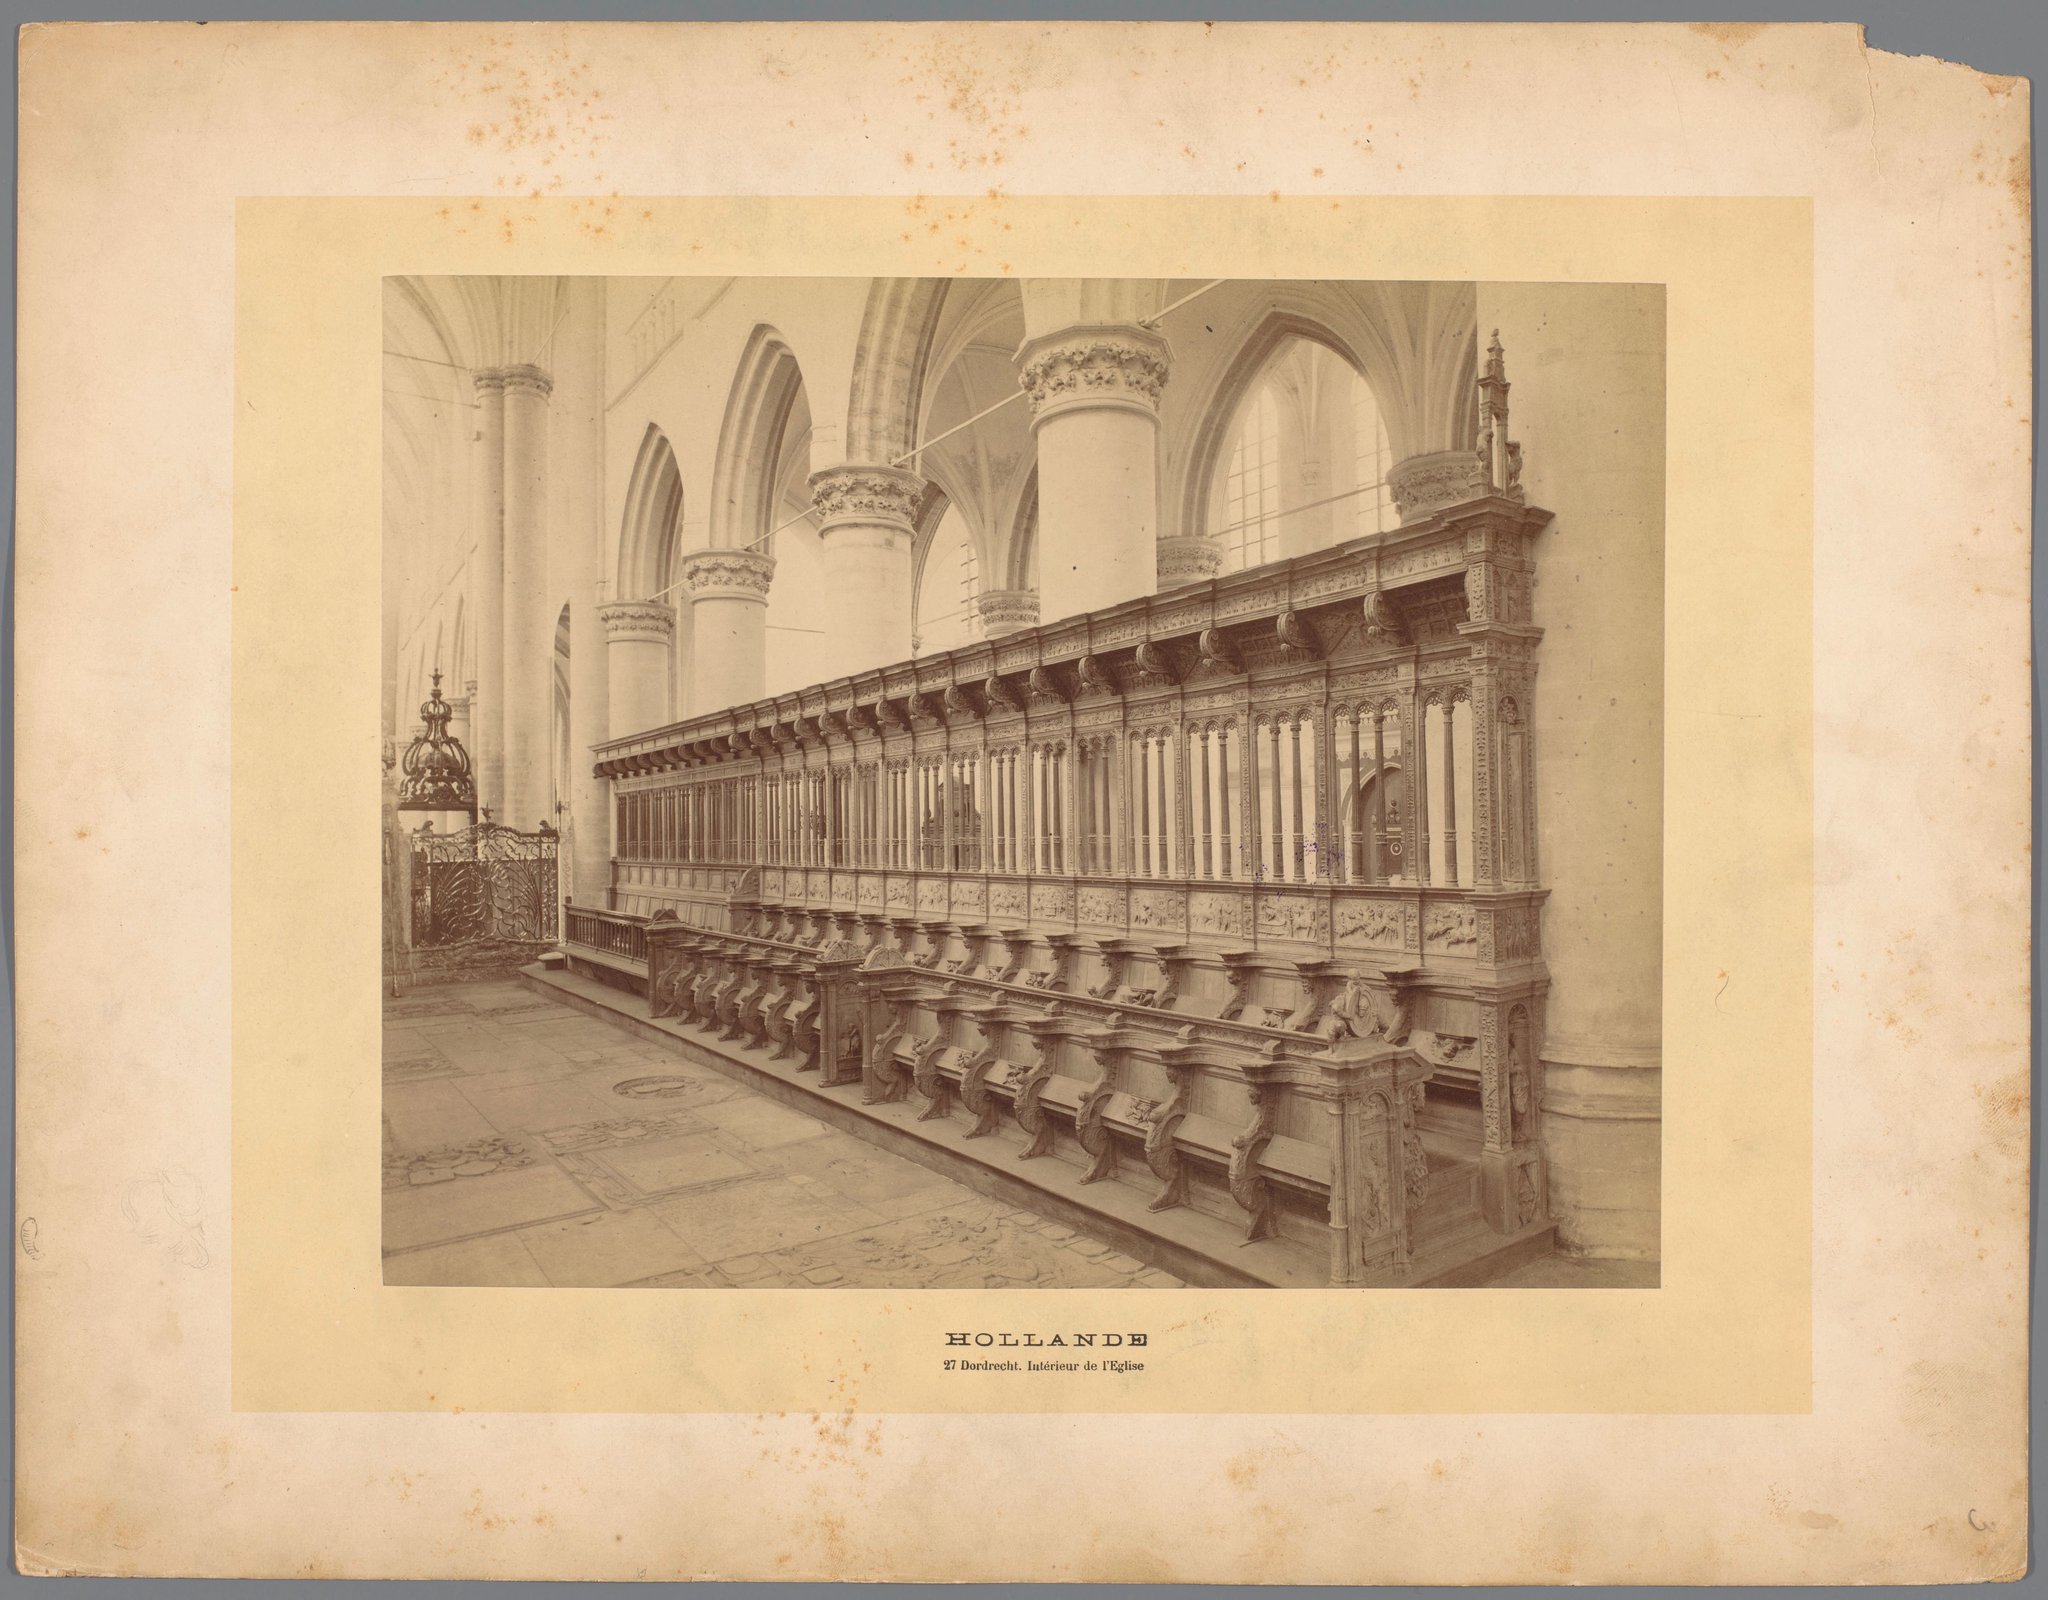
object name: photograph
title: Koorbanken in de Grote Kerk te Dordrecht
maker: Anonymous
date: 1875-1900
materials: cardboard, photographic support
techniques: albumen print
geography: grote of onze-lieve-vrouwekerk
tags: interior of church, seats of the clergy, choir-stalls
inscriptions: number: ‘27’, collector's mark: Lugt 3937, inscription: ‘HOLLANDE Dordrecht. Intérieur de l'Eglise’